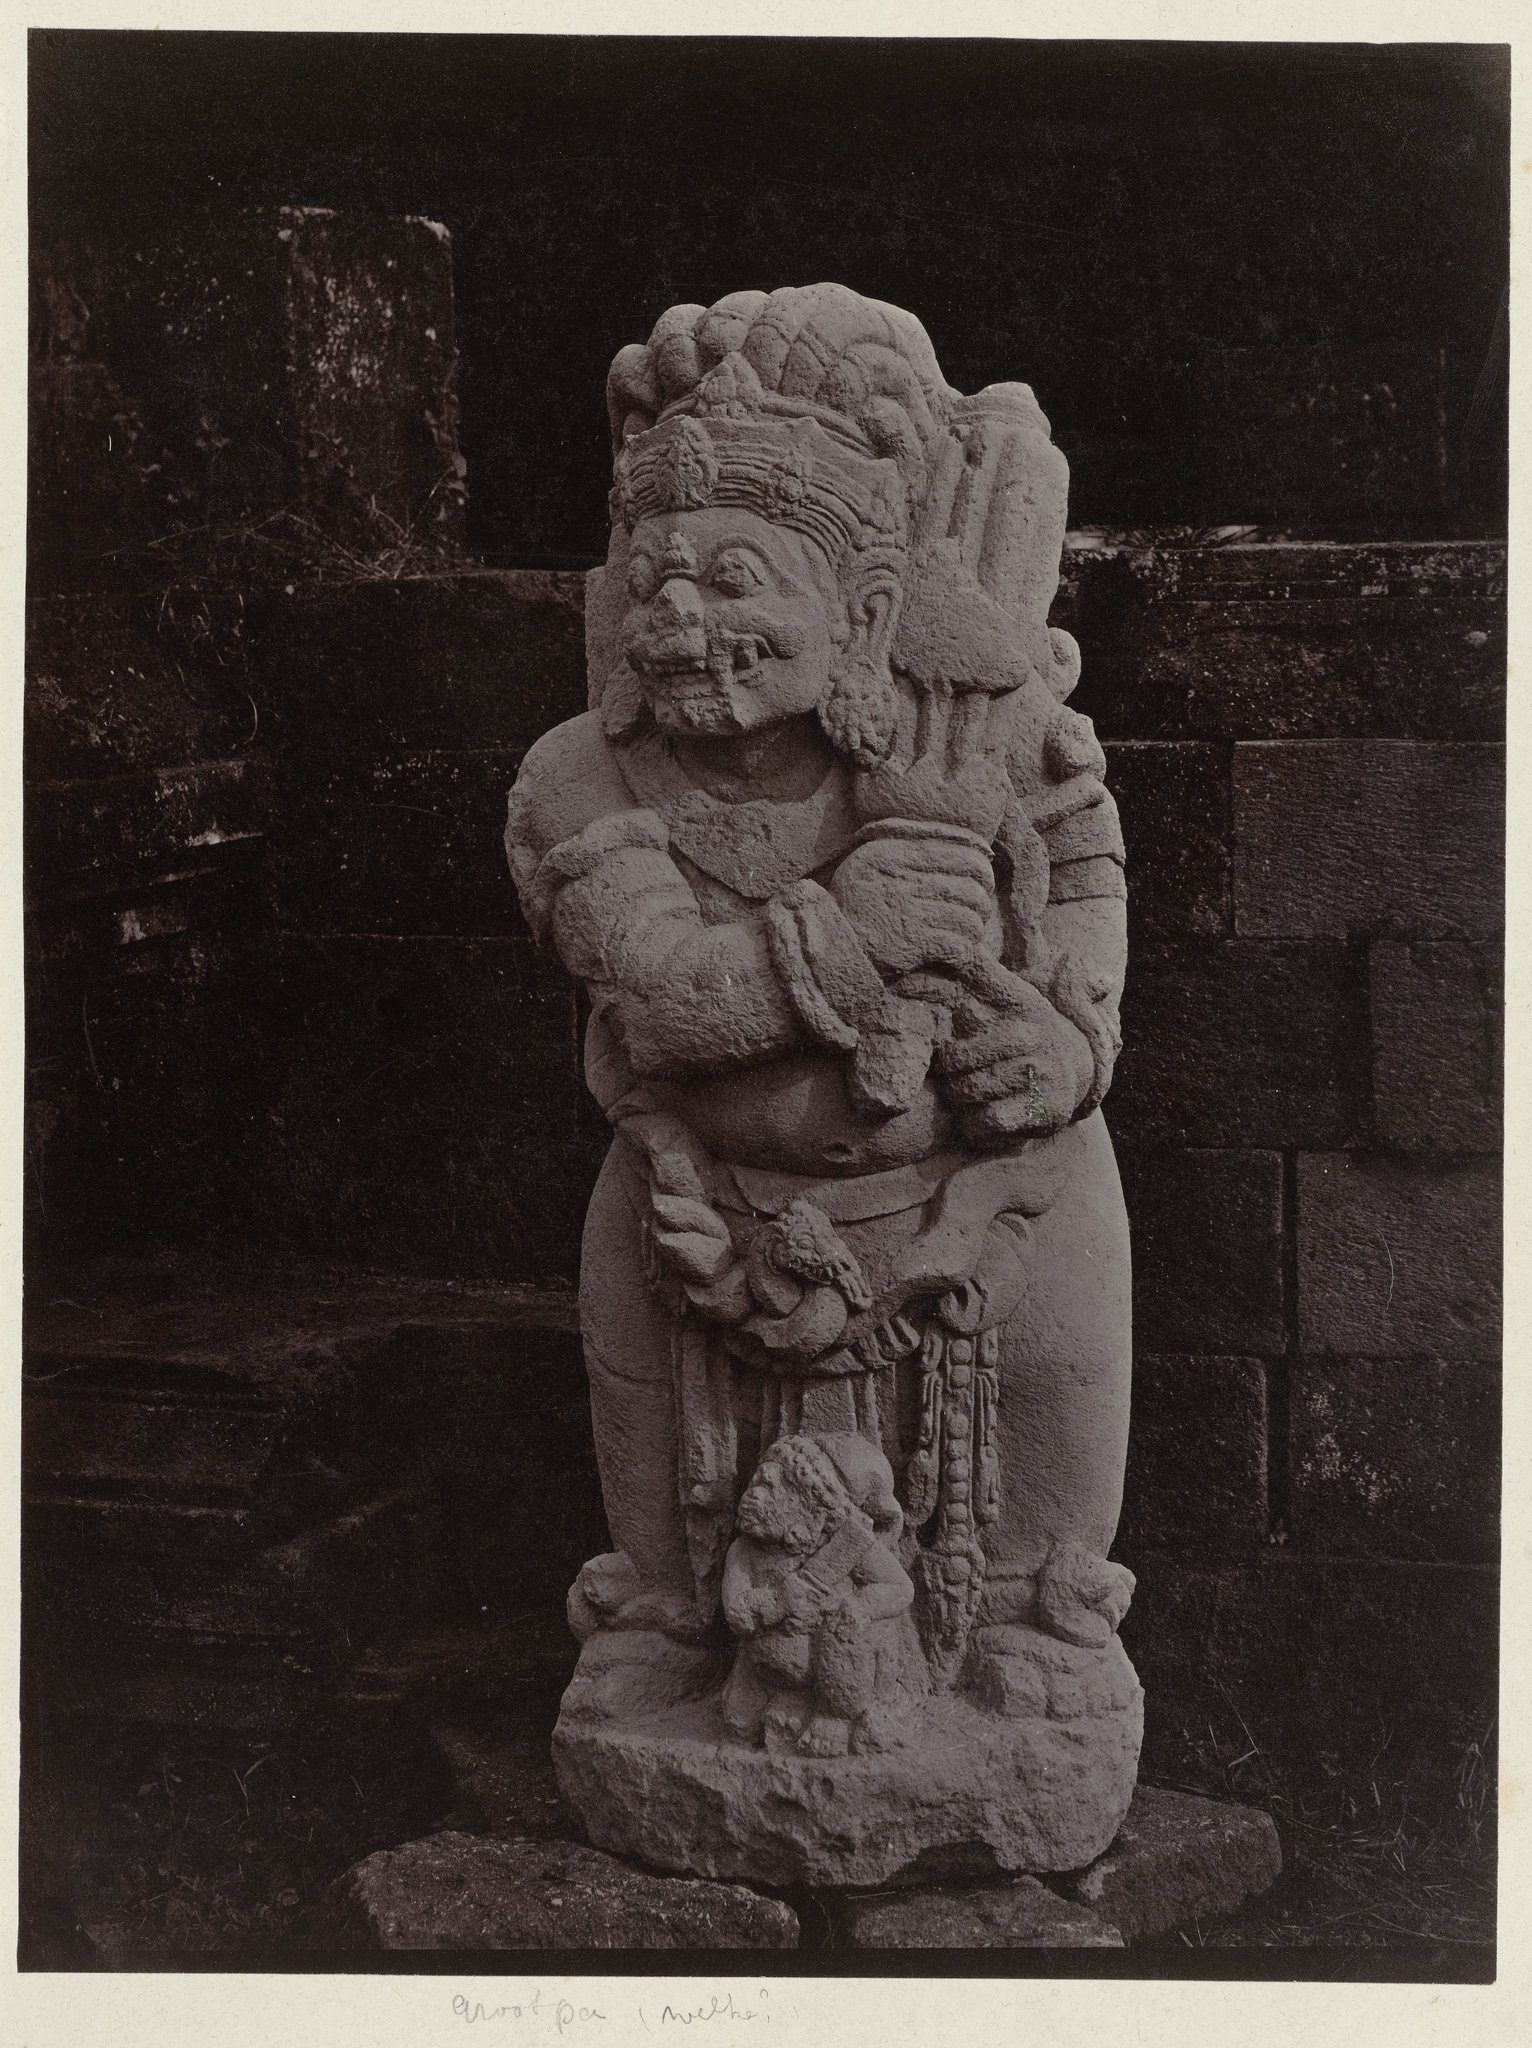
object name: photograph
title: Tempelwachter, gevonden bij een onafgewerkt tempeltje. Panataran (r. Kediri)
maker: isidore kinsbergen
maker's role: fotograaf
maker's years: 1821-1905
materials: cardboard, paper, photographic support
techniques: albumen print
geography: java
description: Candi Panataran (Temple Complex), guardian figure wielding a club. Panataran, Blitar district, East Java province, 1375 AD